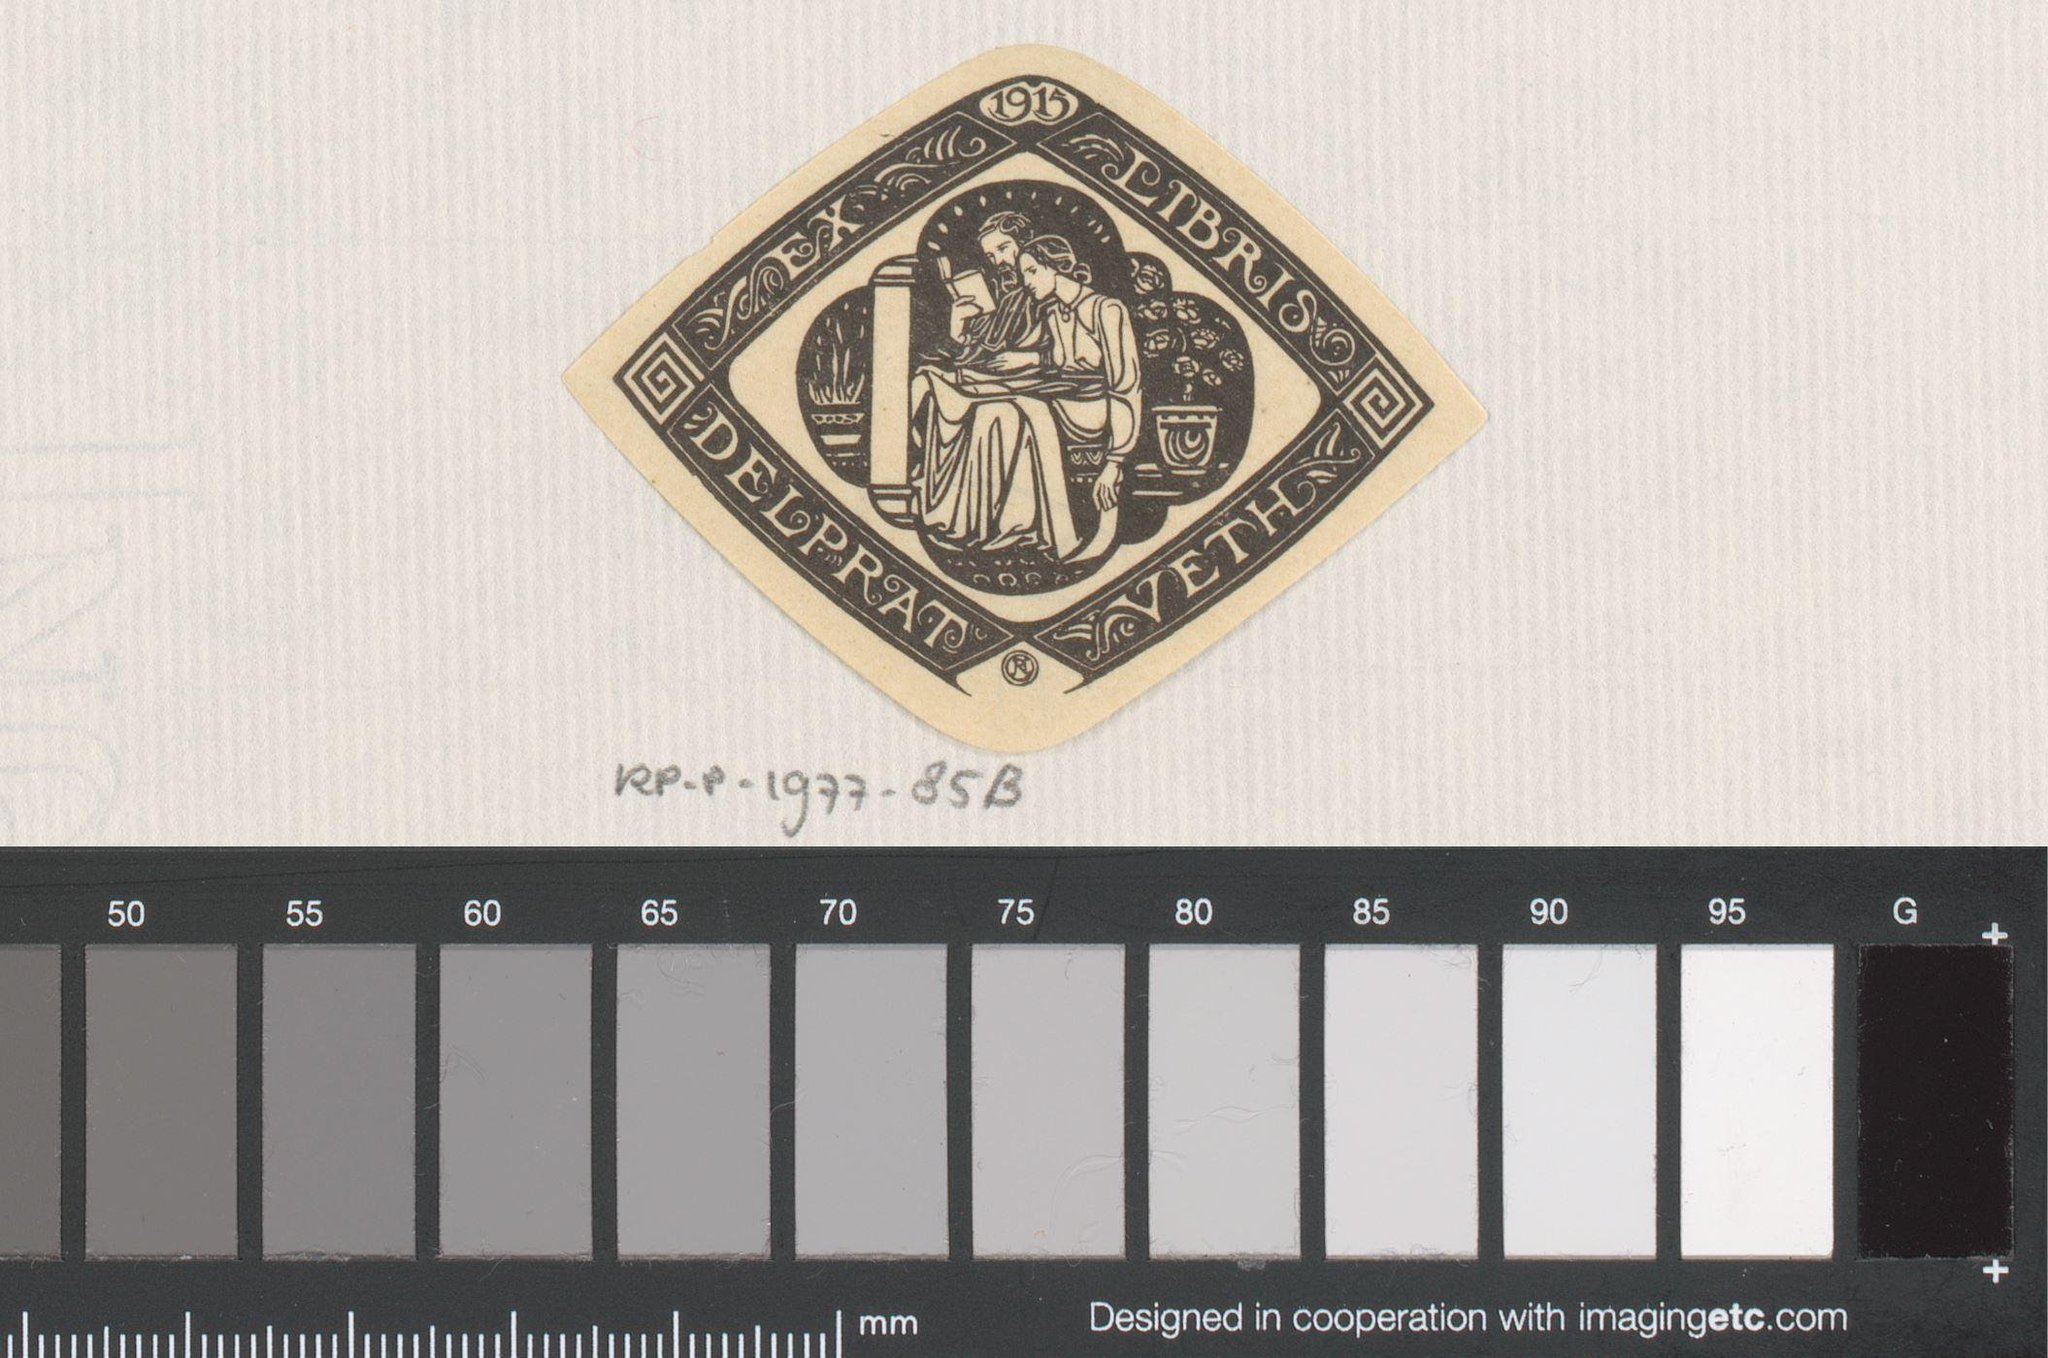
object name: bookplate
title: Ex libris van Delprat-Veth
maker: Anonymous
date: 1915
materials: paper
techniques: printing block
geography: netherlands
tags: saskia delprat-veth, politician, daniel apollonius delprat, reading, book, couple of lovers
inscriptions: collector's mark: Lugt 2228